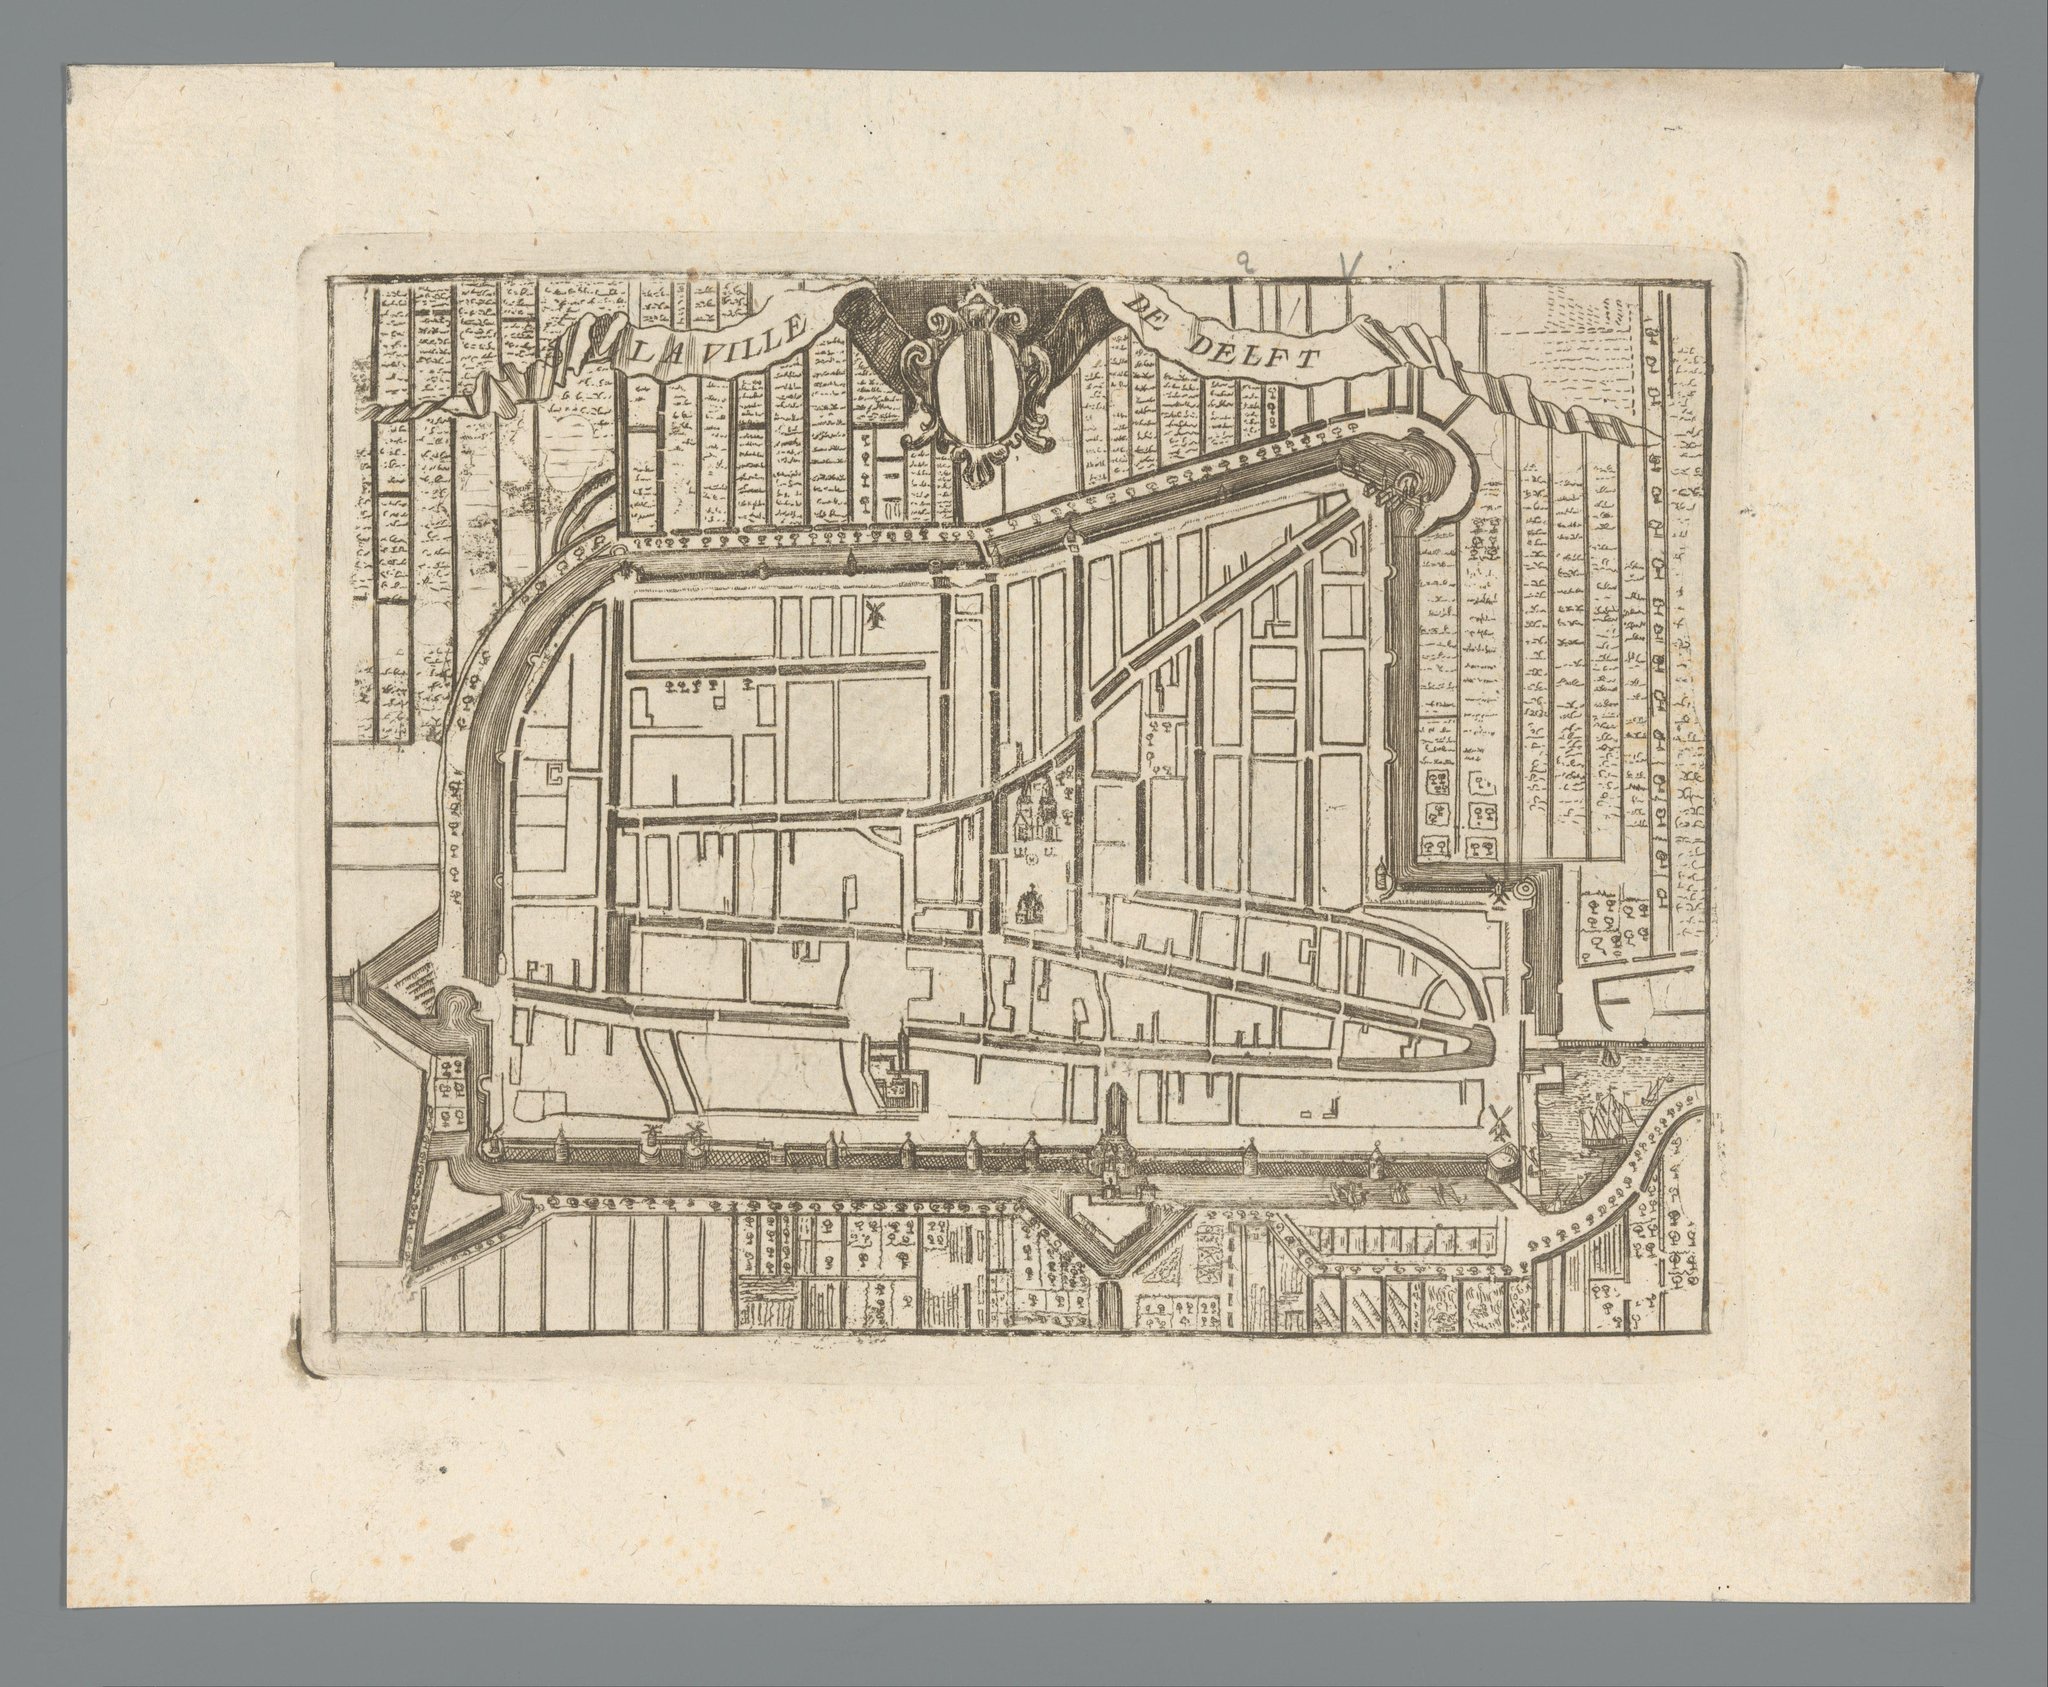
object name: area plan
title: La Ville de Delft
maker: Anonymous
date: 1650-1700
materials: paper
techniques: etching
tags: maps of cities, delft